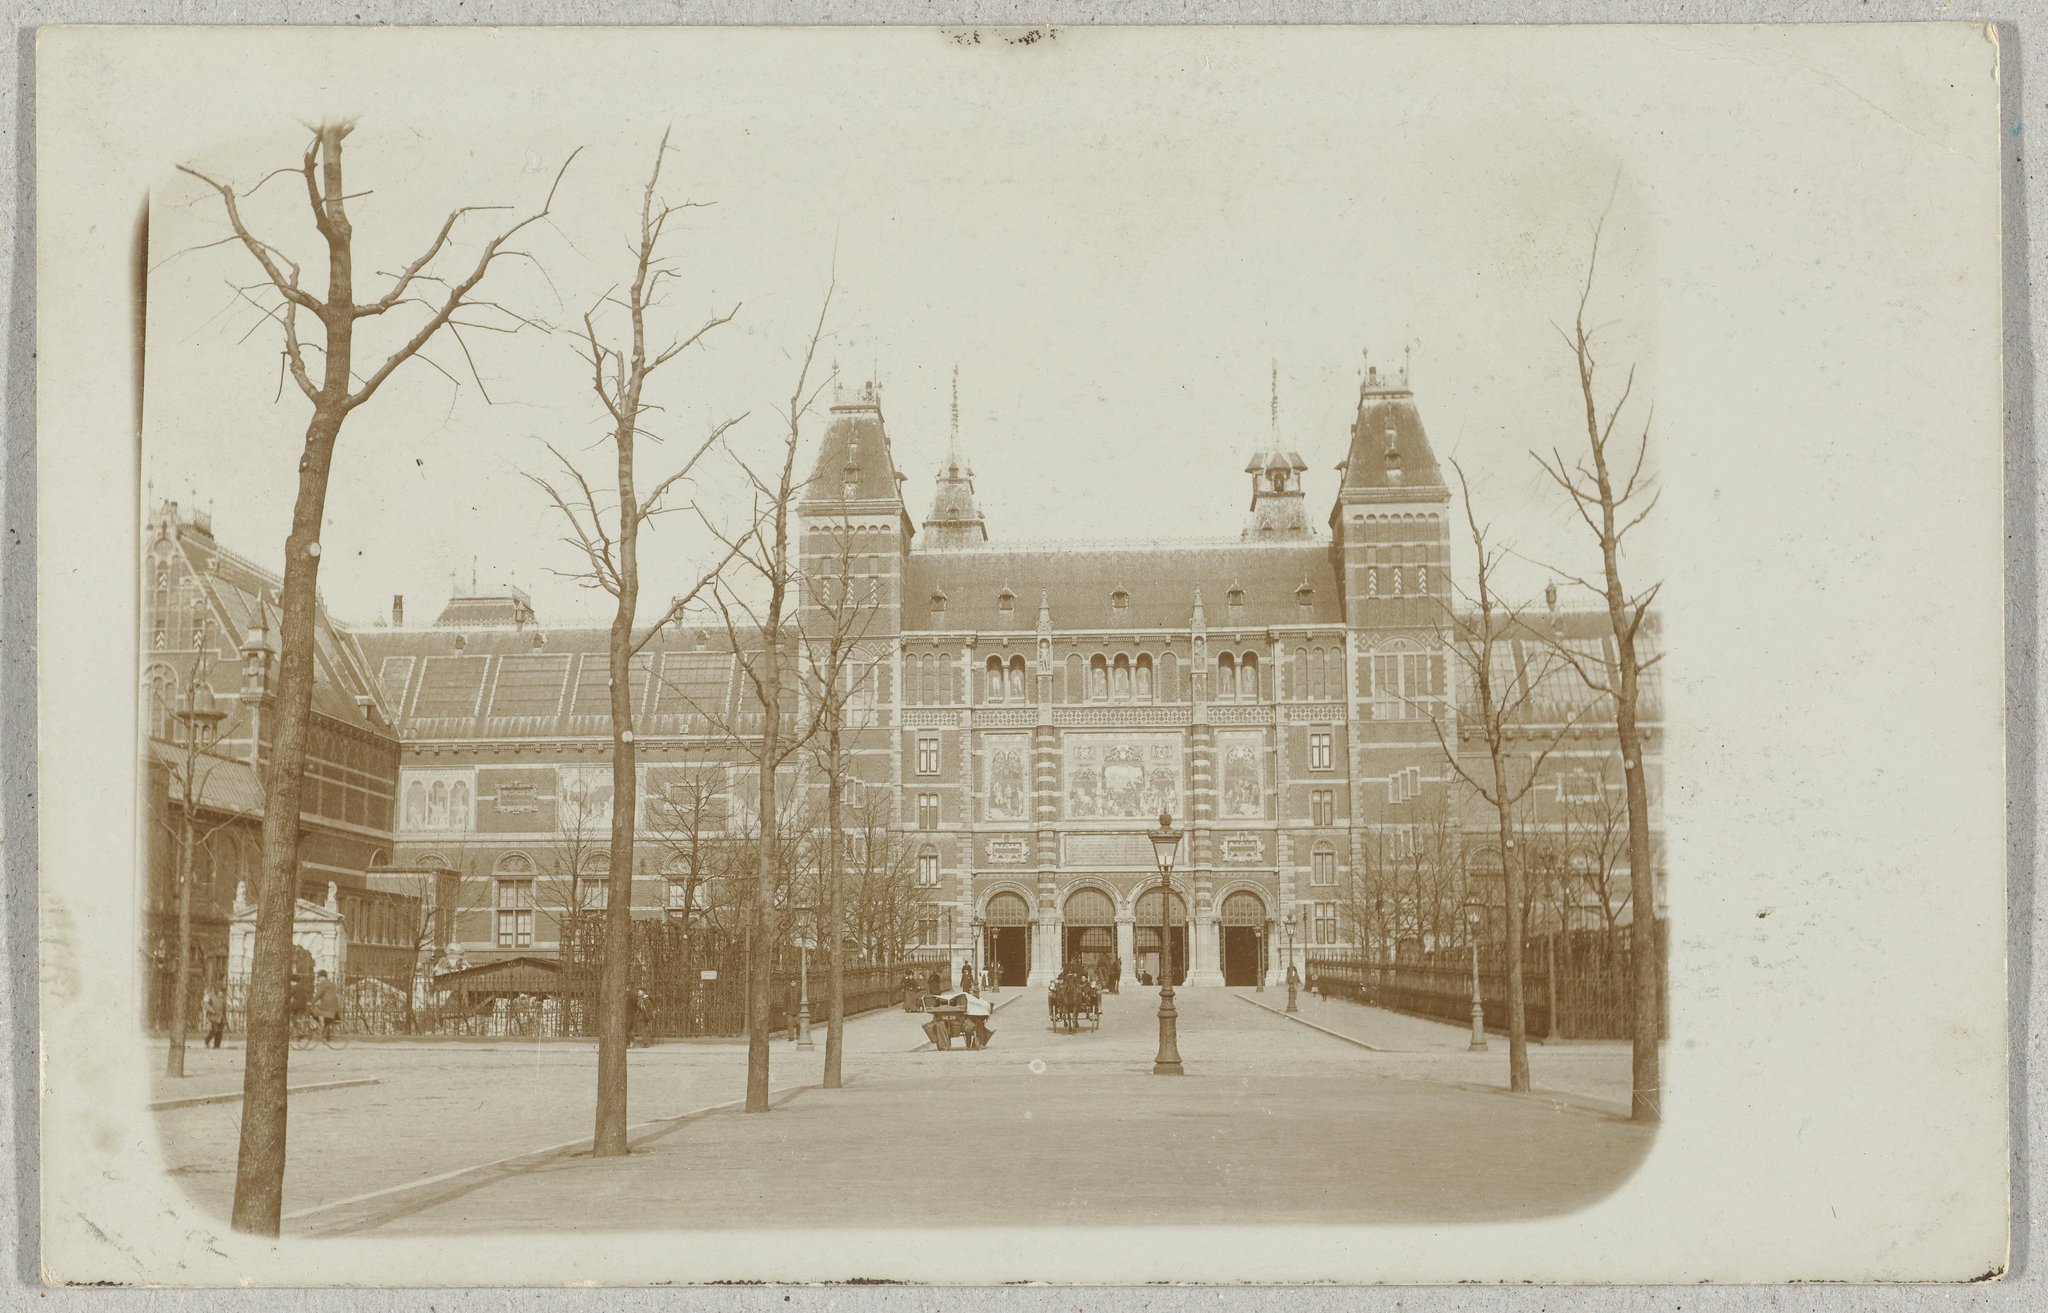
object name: photograph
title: Het Rijksmuseum gezien vanaf de zijde van het Museumplein in Amsterdam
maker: Anonymous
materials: paper, photographic support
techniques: collodion silver print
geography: netherlands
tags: permanent exhibition, museum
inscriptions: inscription: ‘BRIEFKAART / (CARTE POSTALE) / Aan’